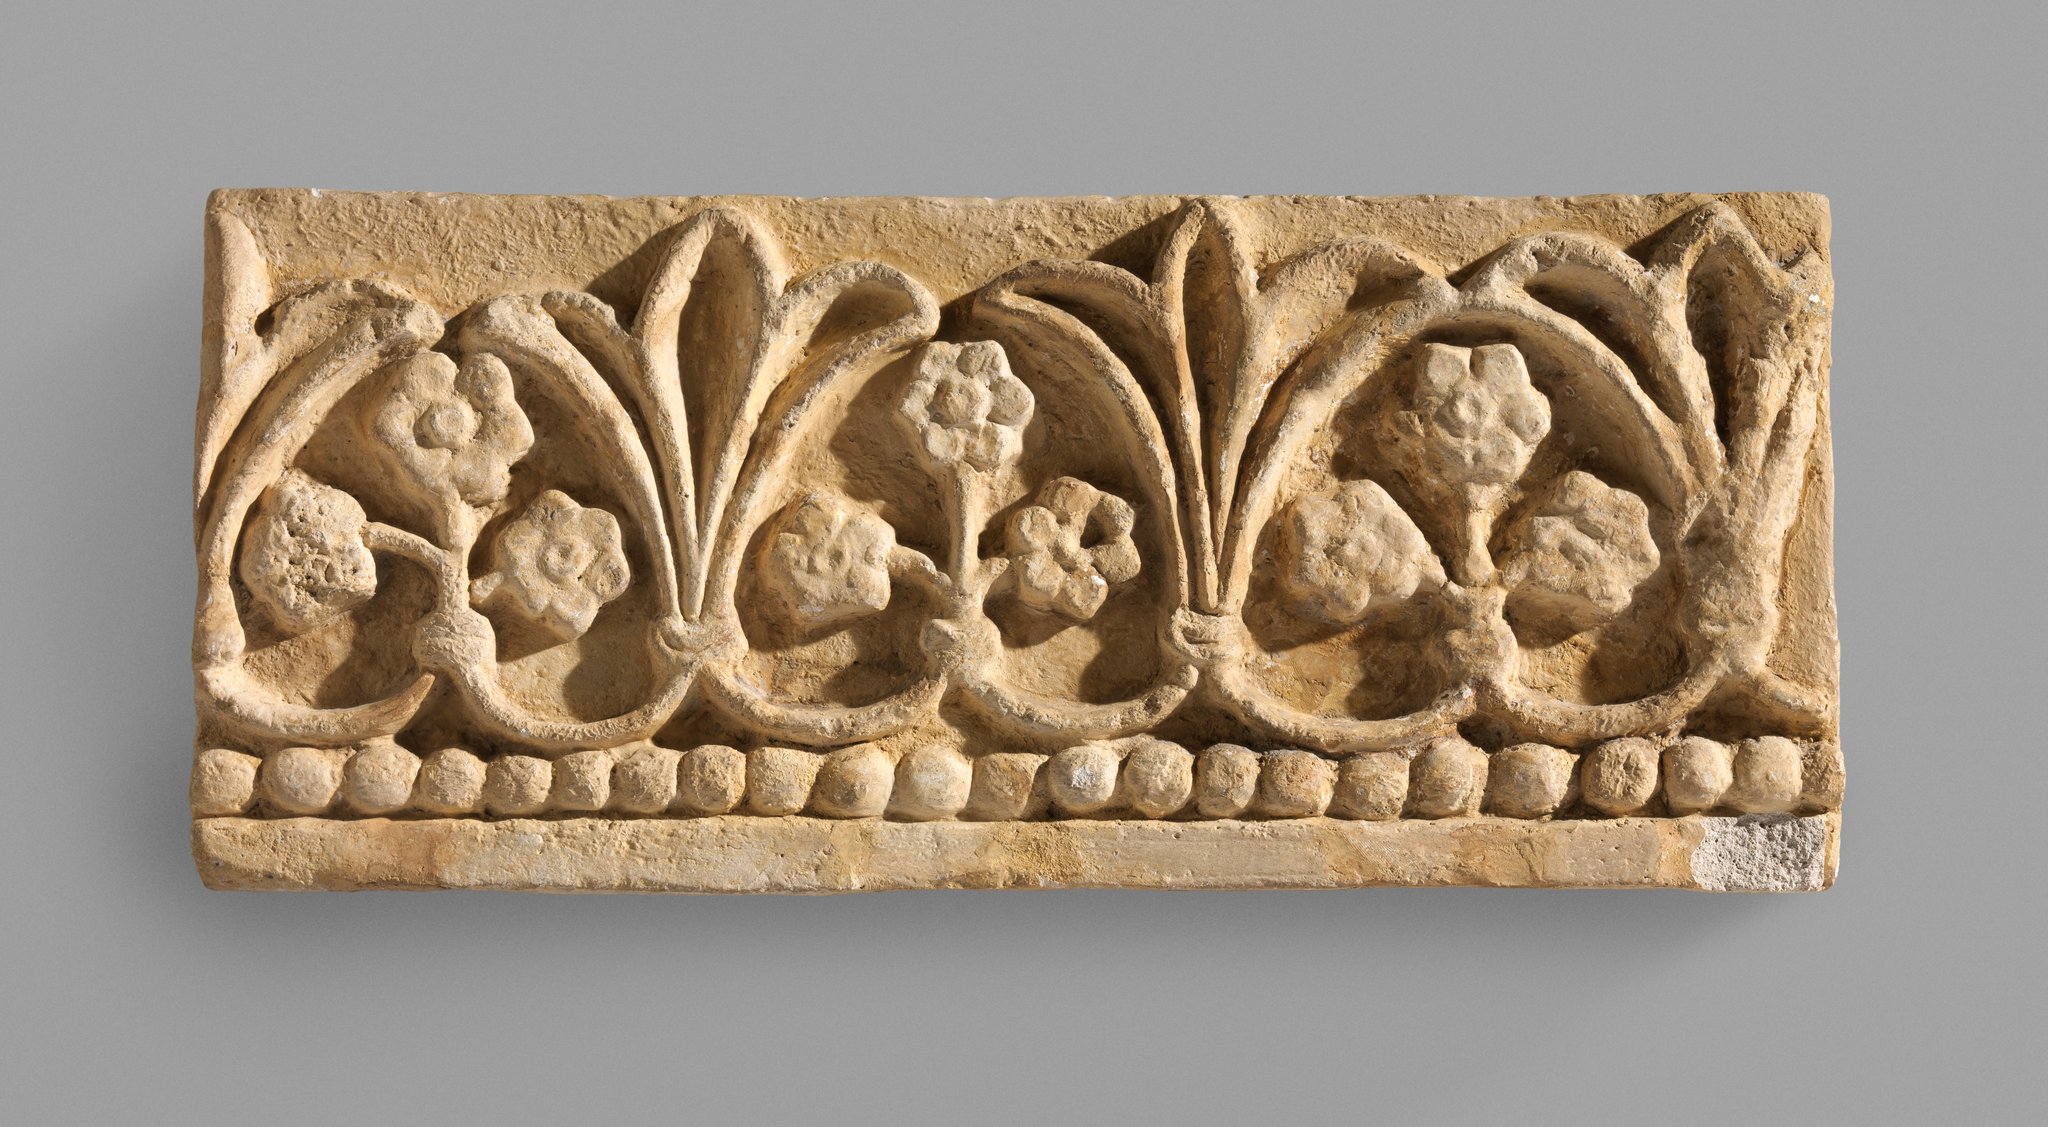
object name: relief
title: Wall decoration with floral and vegetal design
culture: sasanian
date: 501-600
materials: plaster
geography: mesopotamia